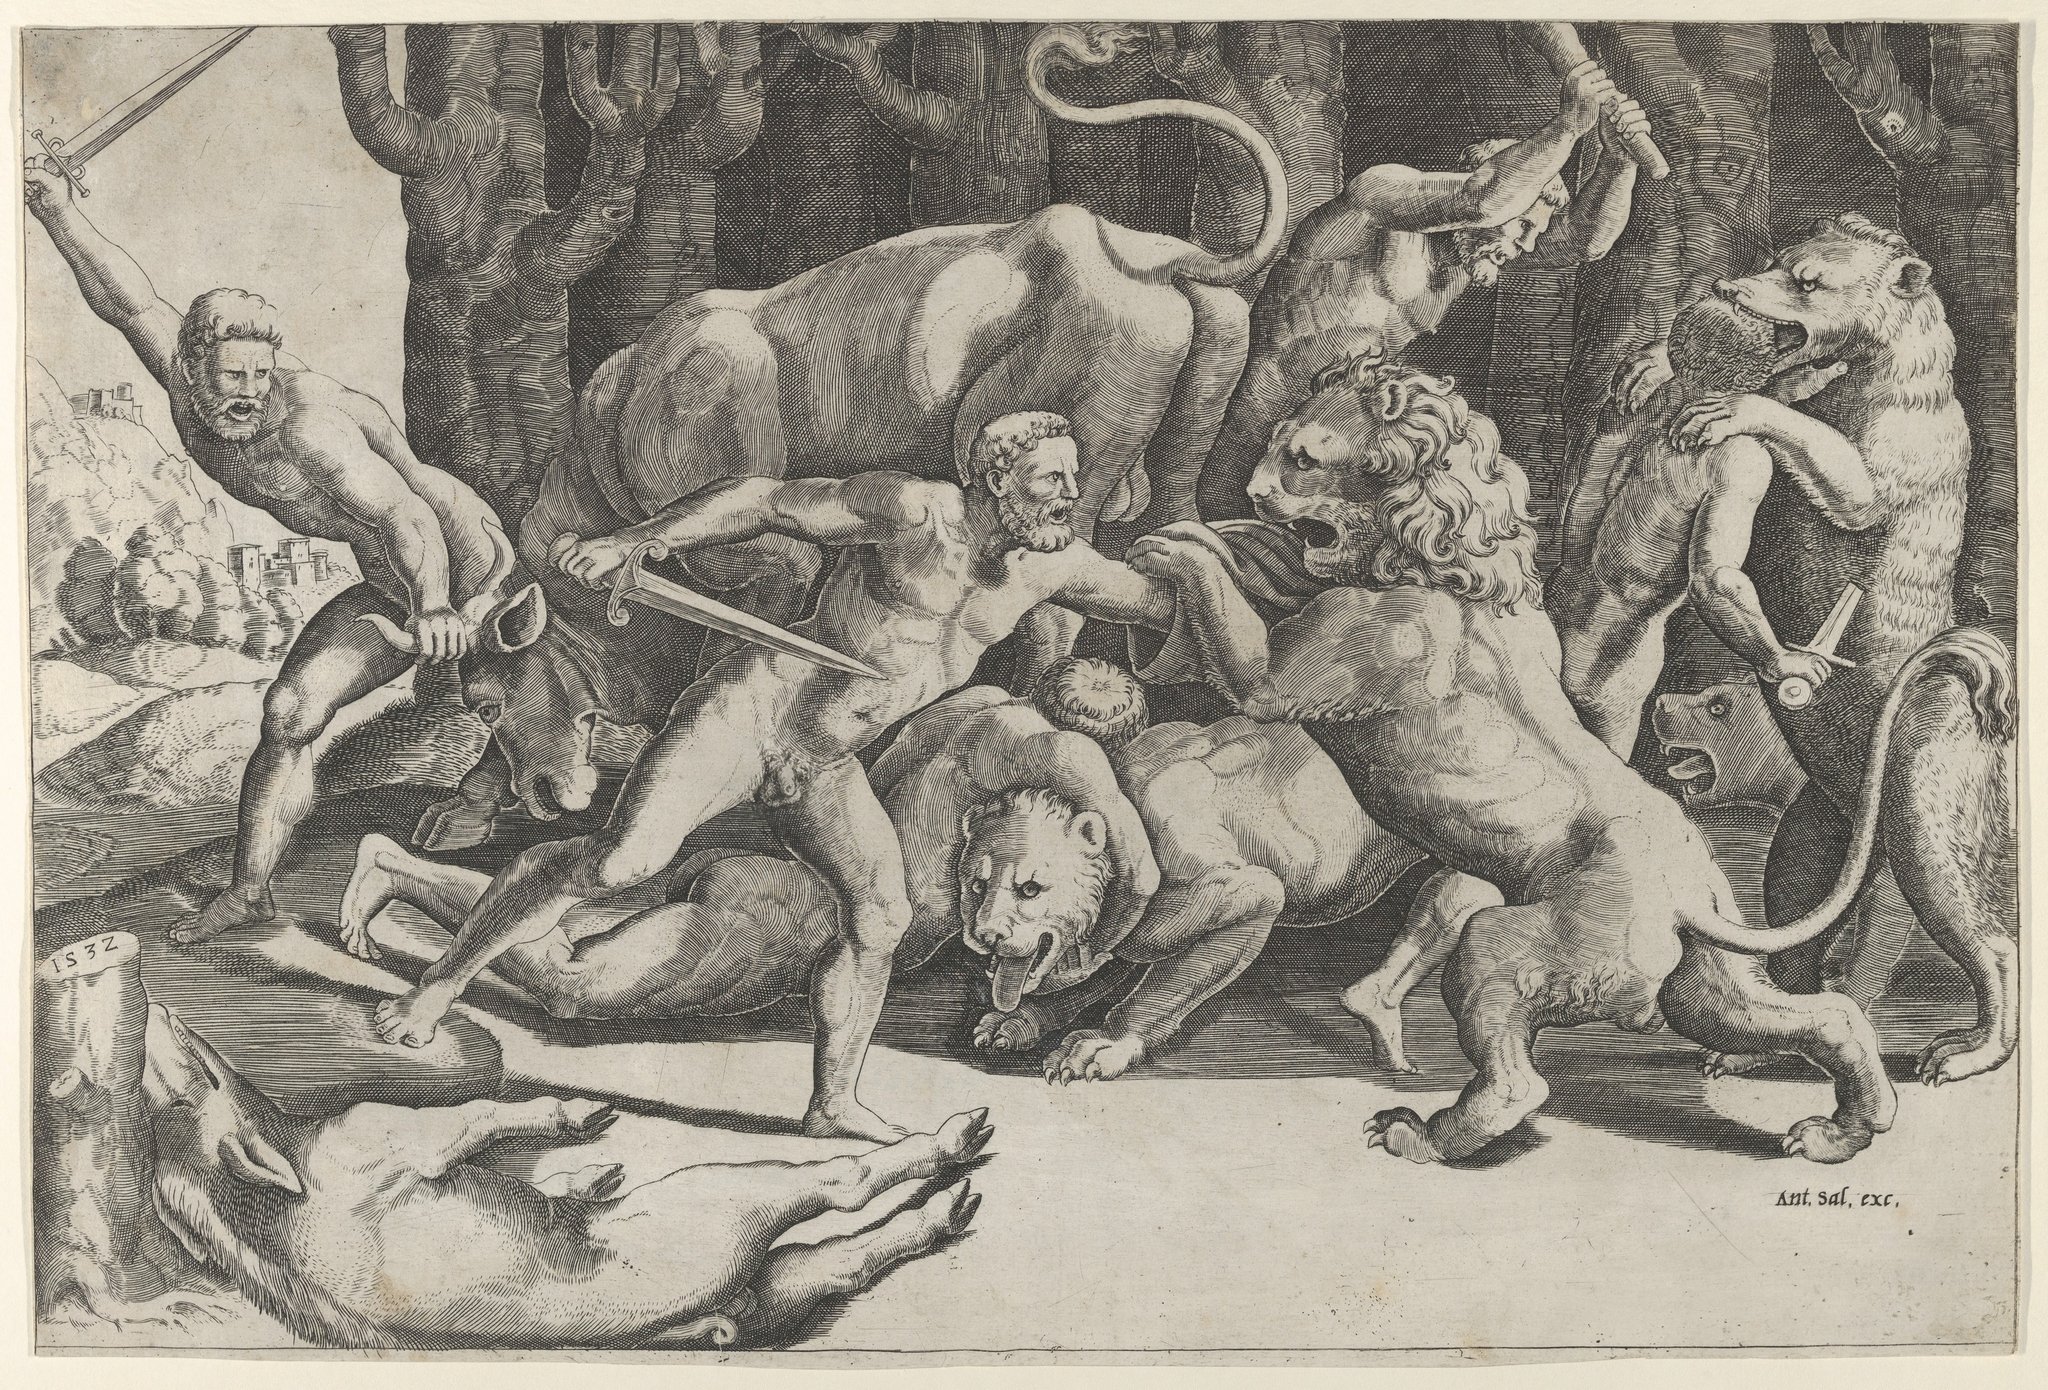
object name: print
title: Five men fighting beasts, at lower left is a fallen boar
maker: master of the die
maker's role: artist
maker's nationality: italian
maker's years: 1525-1560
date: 1532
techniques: engraving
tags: swords,male nudes,boars,lions